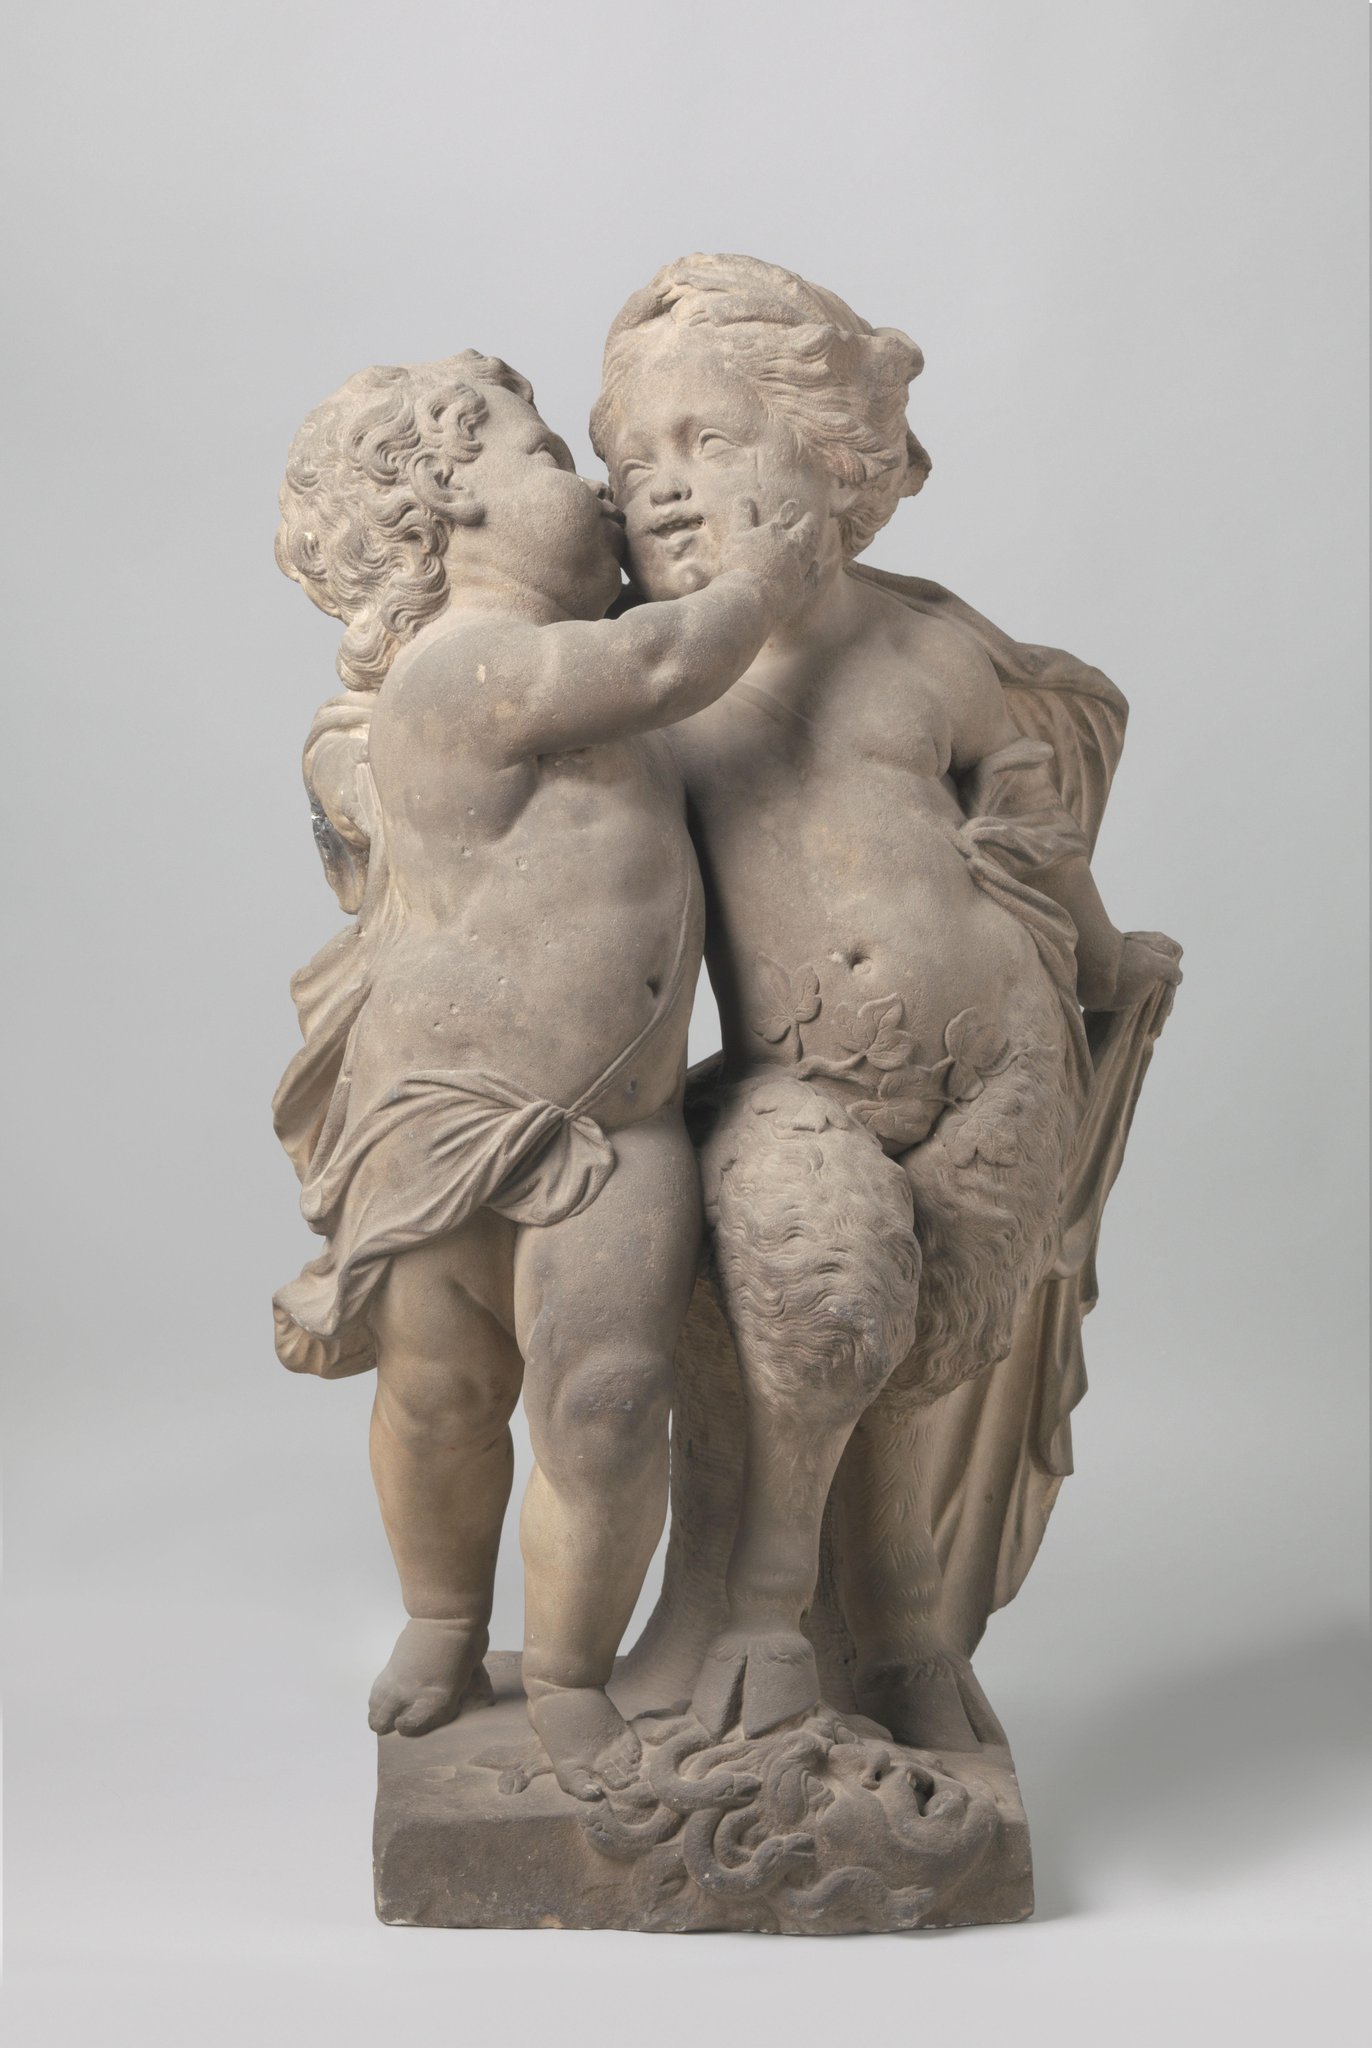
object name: sculpture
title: A Girl Kissing a Satyr Boy, Allegory of Love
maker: jan pieter van baurscheit (i)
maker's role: draughtsman, sculptor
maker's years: 1669-1728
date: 1720-1730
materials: stone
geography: antwerp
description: Attributed to Jacob Vennekool (?- 1711). Two allegorical groups of children: Love and Hatred. Sandstone. Holland, c. 1700